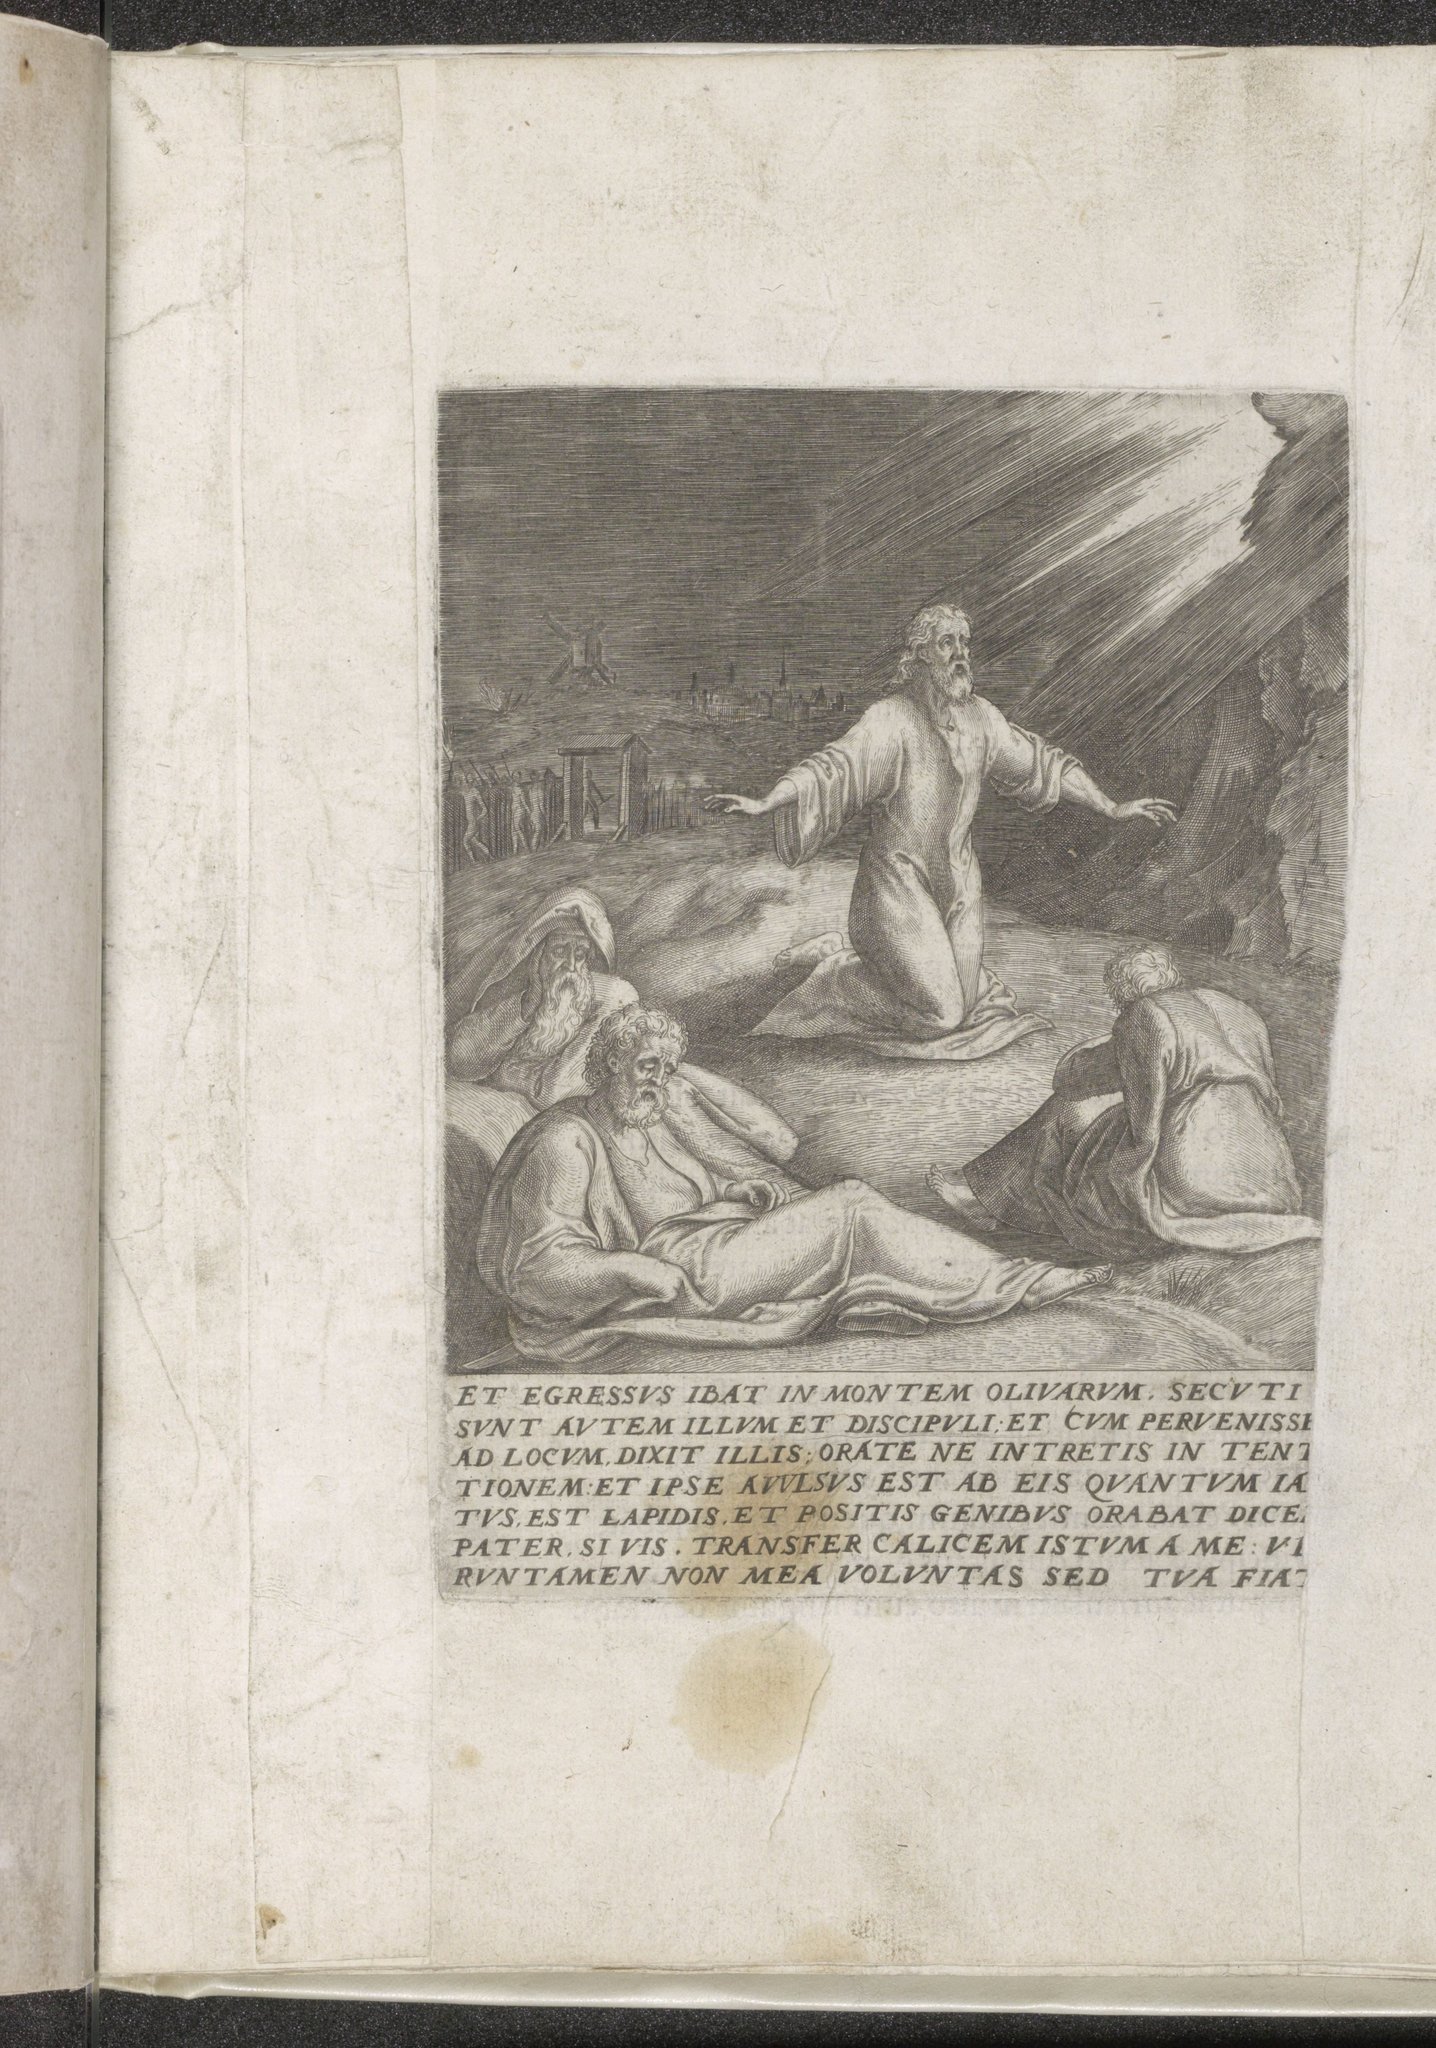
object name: album leaf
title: Passie van Christus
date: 1572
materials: paper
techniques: engraving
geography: antwerp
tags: agony of christ; three (or eleven) apostles sleeping, christ's prayer in the garden of gethsemane during the night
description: Tijdens de restauratie in 1988 bleek dat op de achterzijde van de prenten van de Passie-serie van Wierix Latijnse teksten in boekdruk staan. Deze vormen, wanneer op de juiste wijze in boekvorm gebonden (wat nu in het Heemskerck-album niet het geval is), een toelichting op de passievoorstellingen. Om de teksten zichtbaar te laten zijn de prenten bij de restauratie niet meer met de achterzijde op elkaar geplakt.